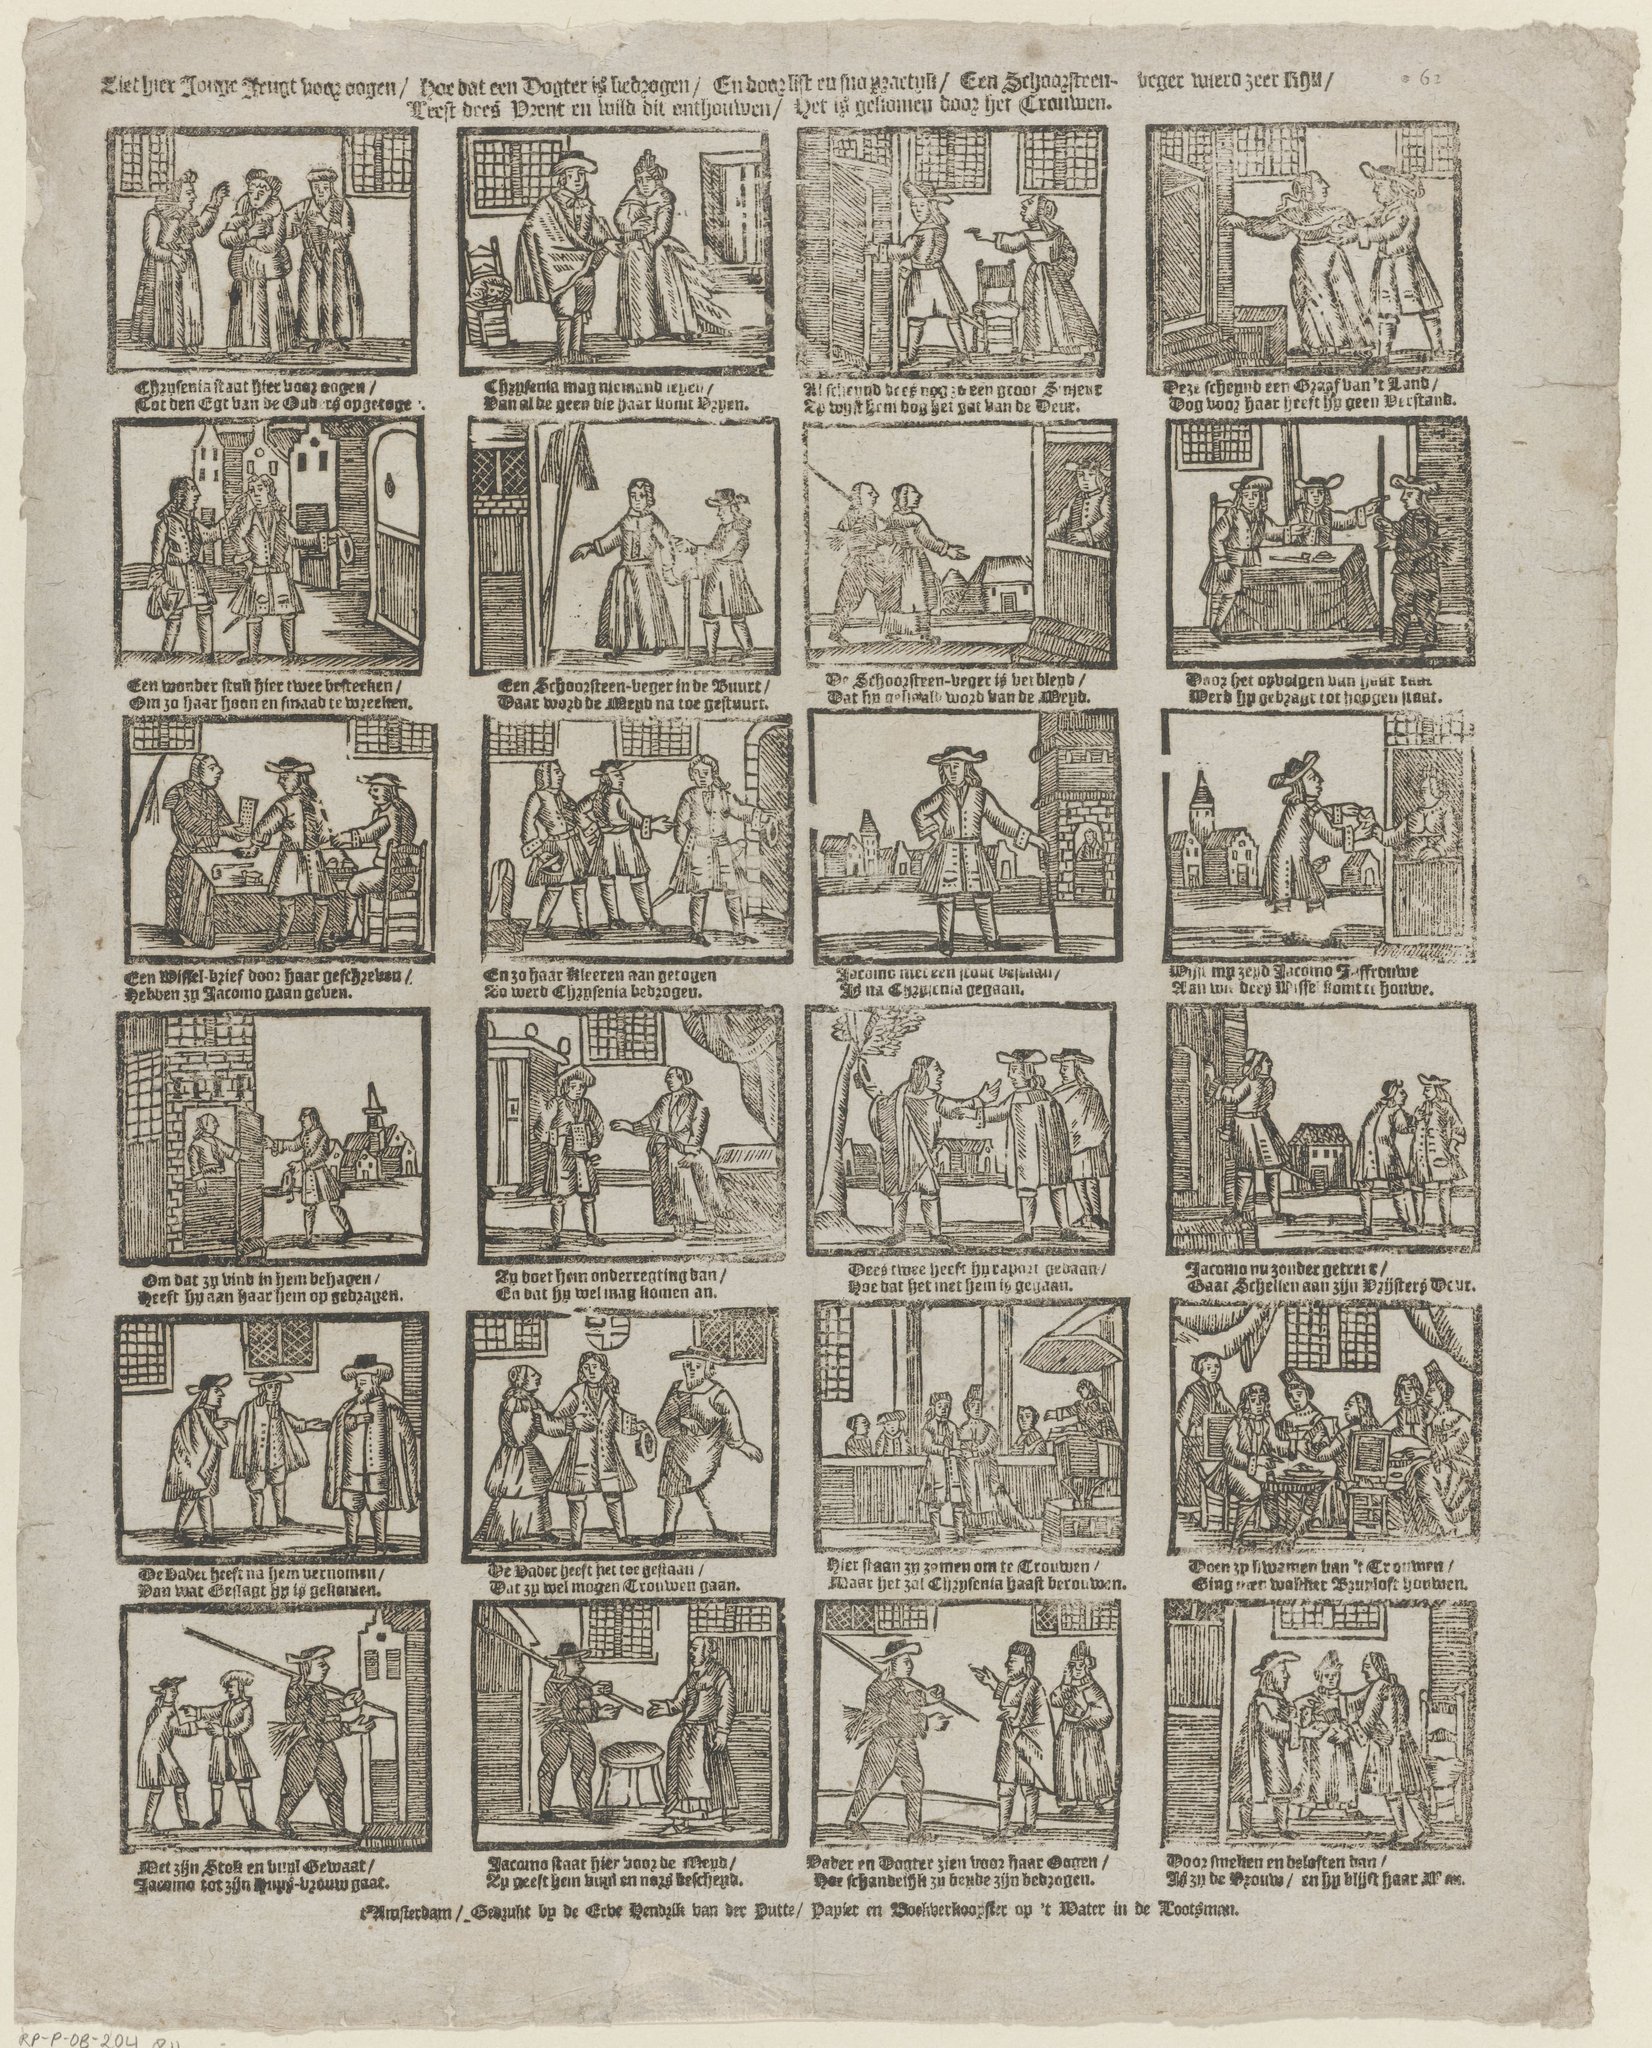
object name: print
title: Ziet hier jonge jeugt voor oogen / hoe dat een dogter is bedrogen [(...)]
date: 1767-1793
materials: paper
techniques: letterpress printing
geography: amsterdam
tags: handicrafts ~ maintenance and repair (with name of trade or profession), betrothal and marriage, marriage contract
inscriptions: collector's mark: Lugt 2760, inscription: ‘[...]CP / o / 1925’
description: Blad met 24 voorstellingen over de rijke Chrysenia die trouwt met een schoorsteenveger. Onder elke afbeelding een tweeregelig vers. Genummerd rechtsboven: *62.